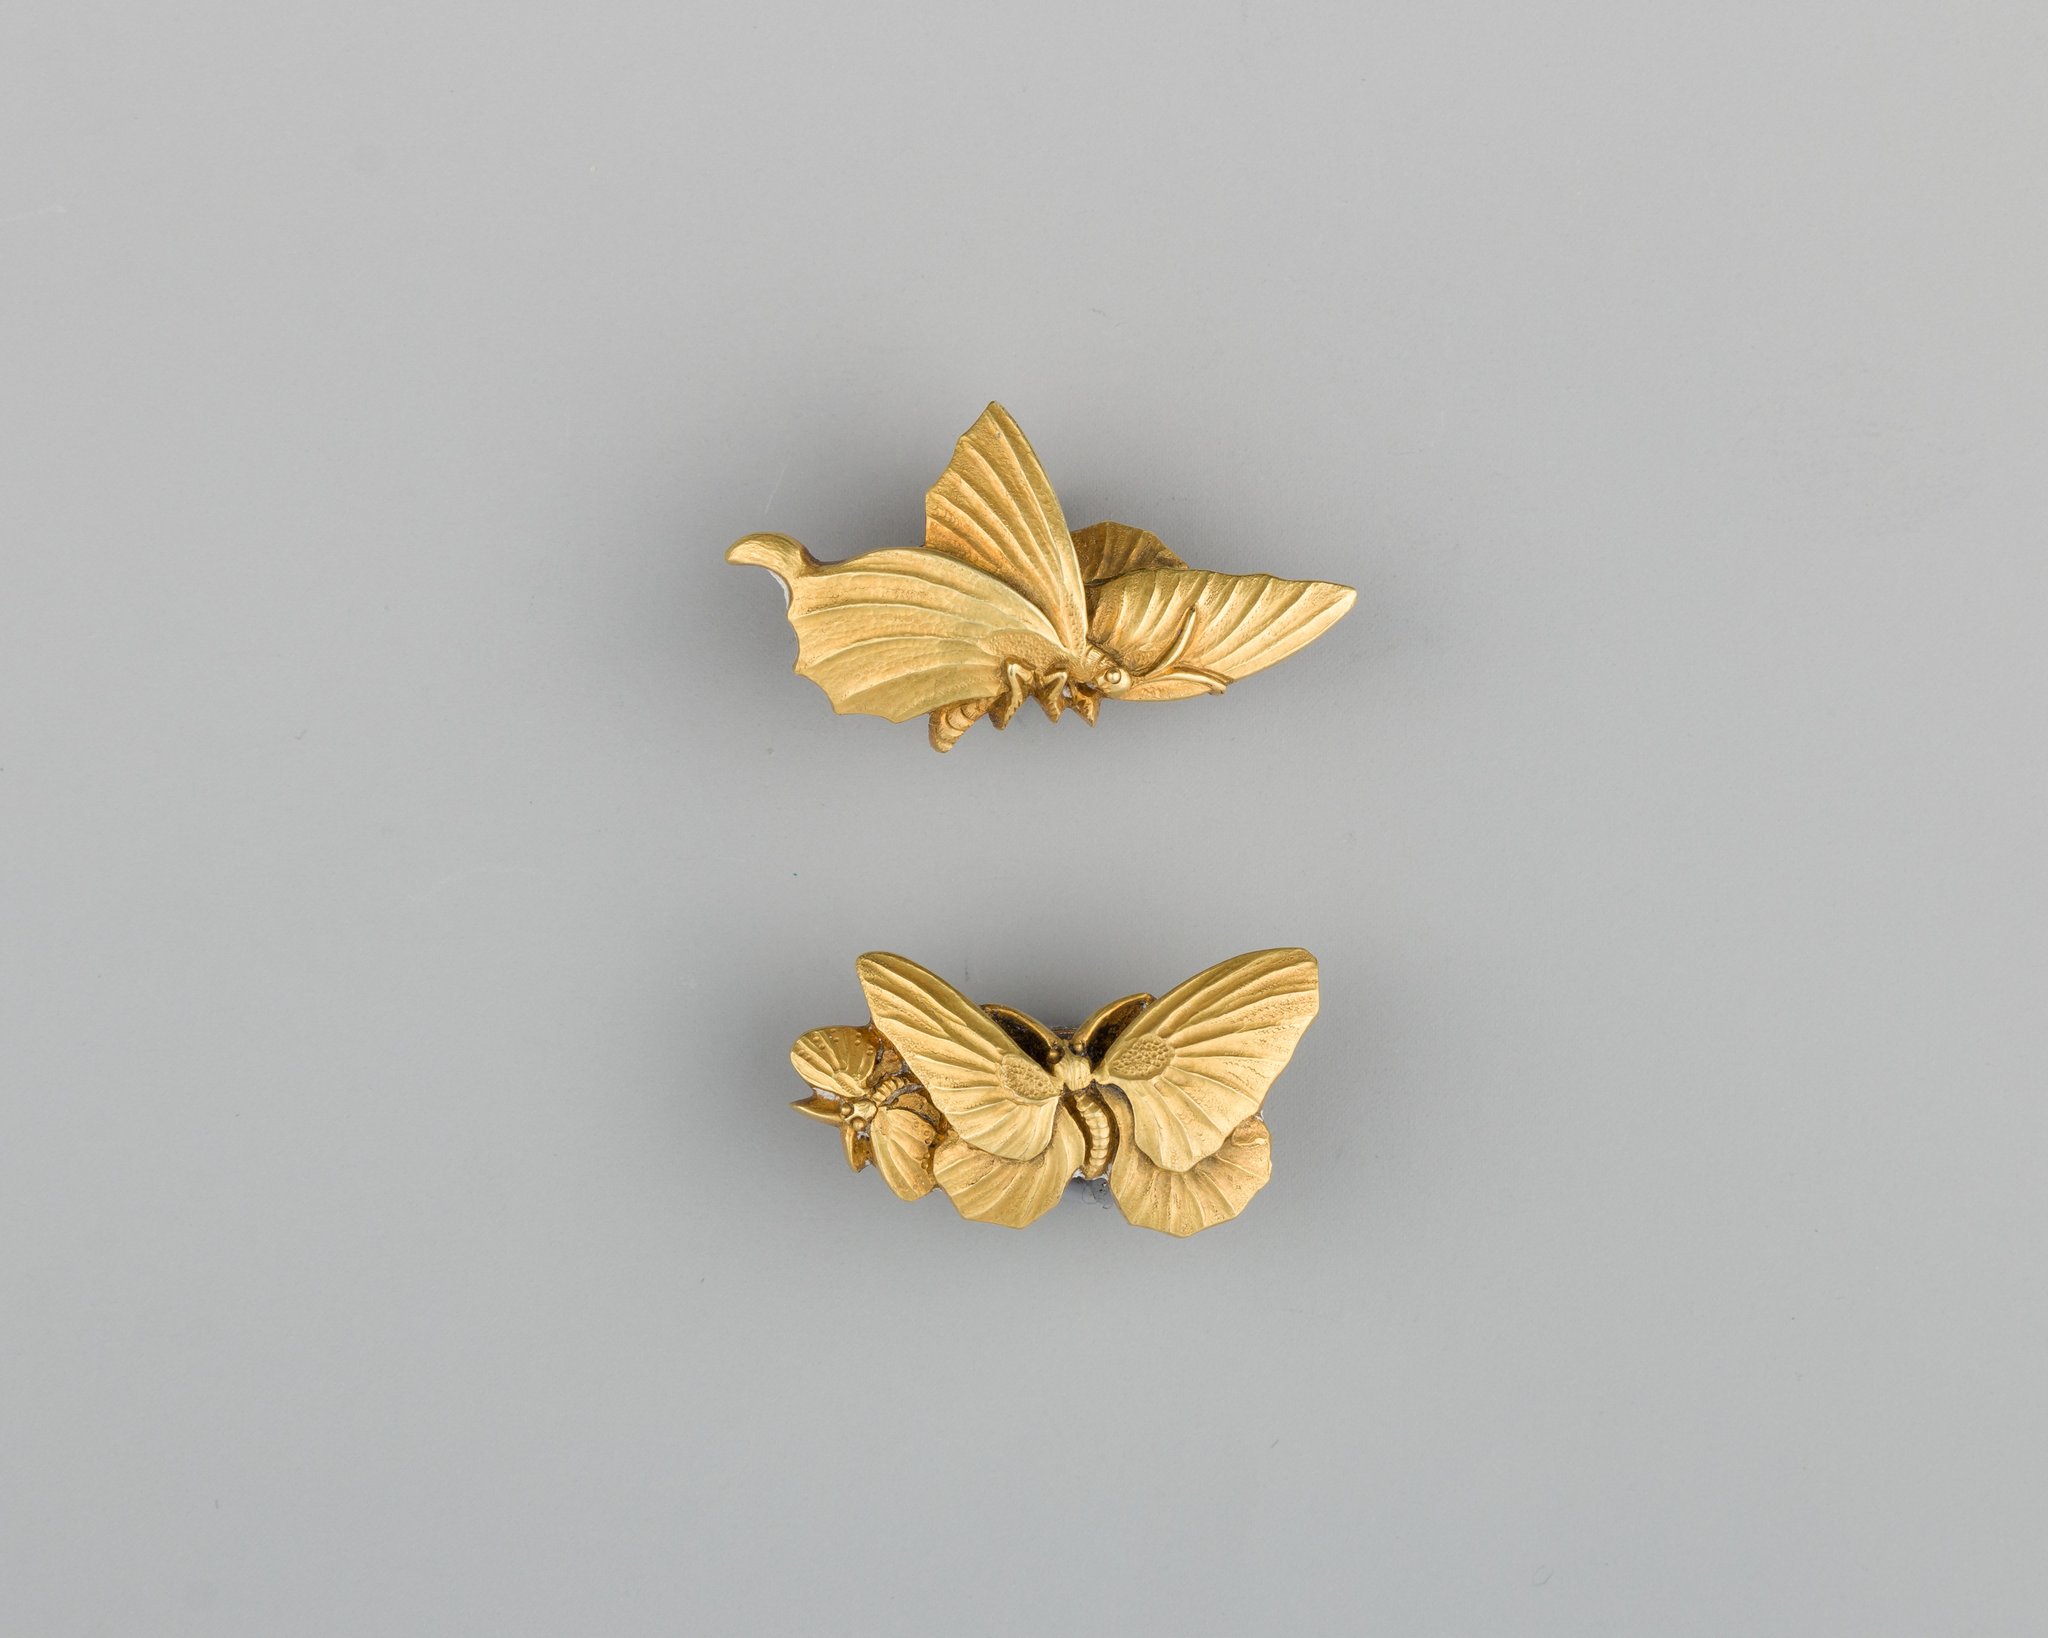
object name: pair of sword grip ornament menuki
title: Pair of Sword-Grip Ornaments (Menuki)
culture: japanese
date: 1701-1800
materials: gold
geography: japan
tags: butterflies